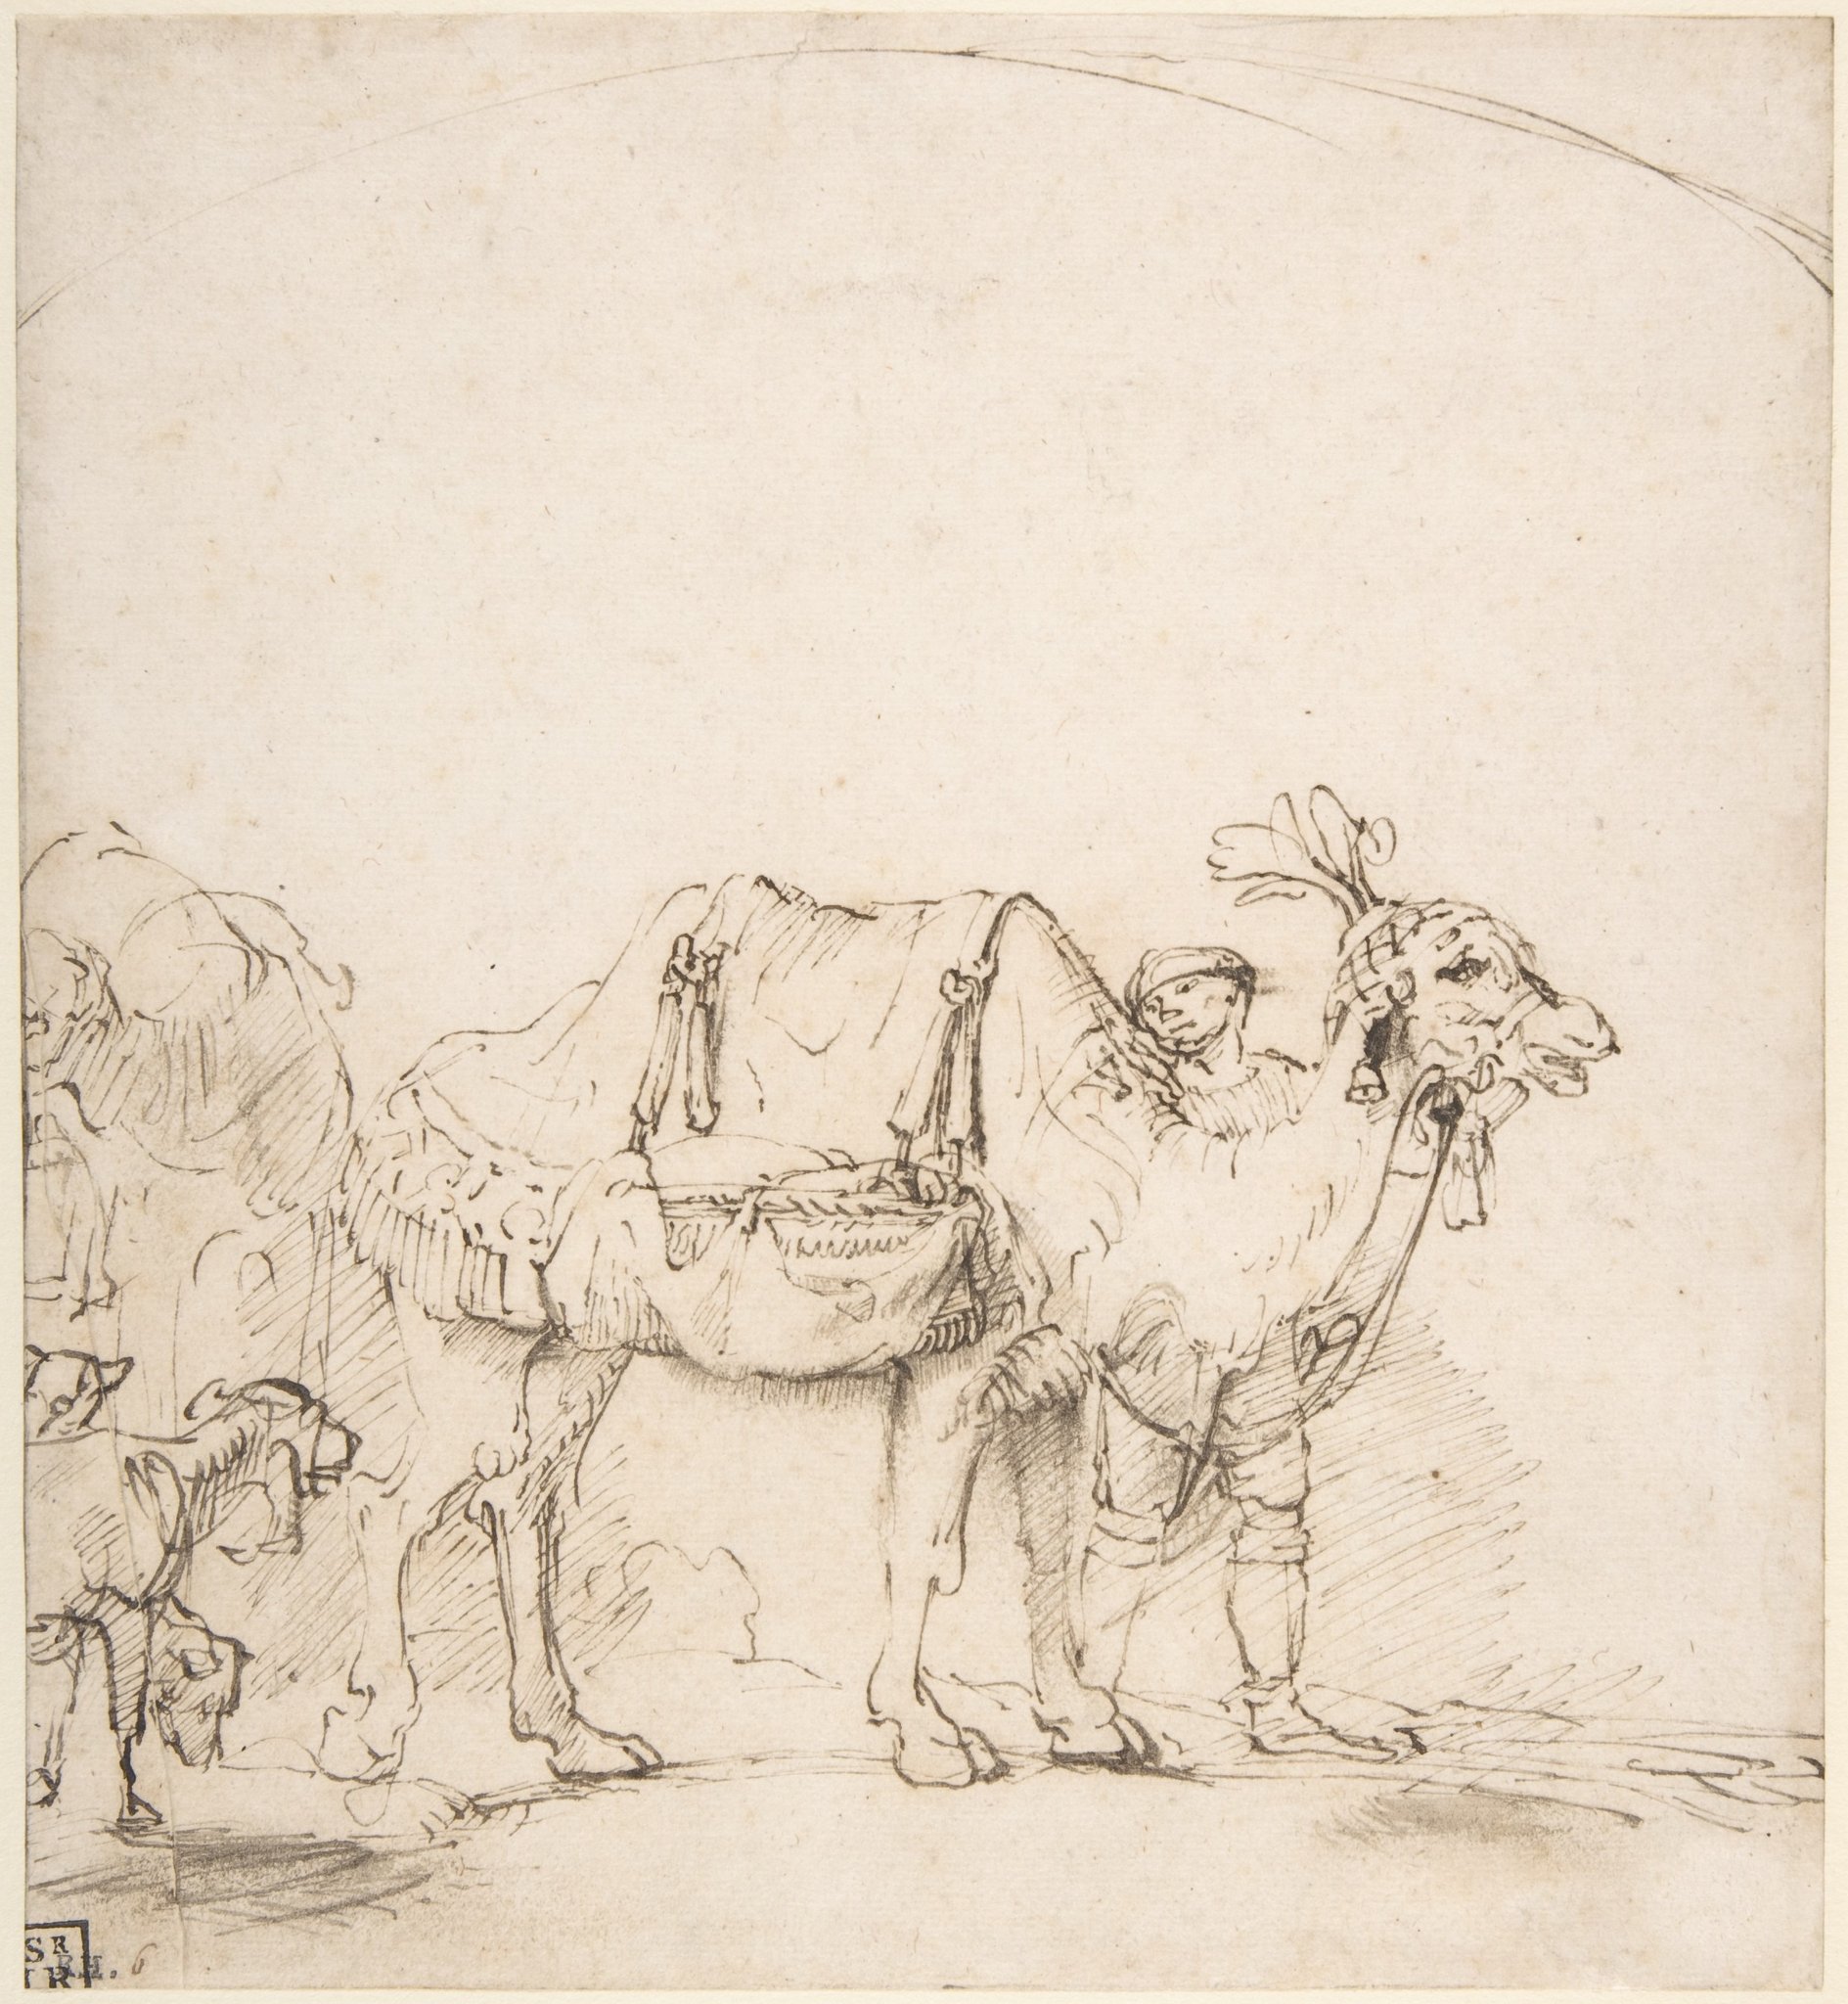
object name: drawing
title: Man Leading a Camel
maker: rembrandt van rijn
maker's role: artist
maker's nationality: dutch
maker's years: 1606-1669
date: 1650-1669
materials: ink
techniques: brush, pen, wash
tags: men,camels